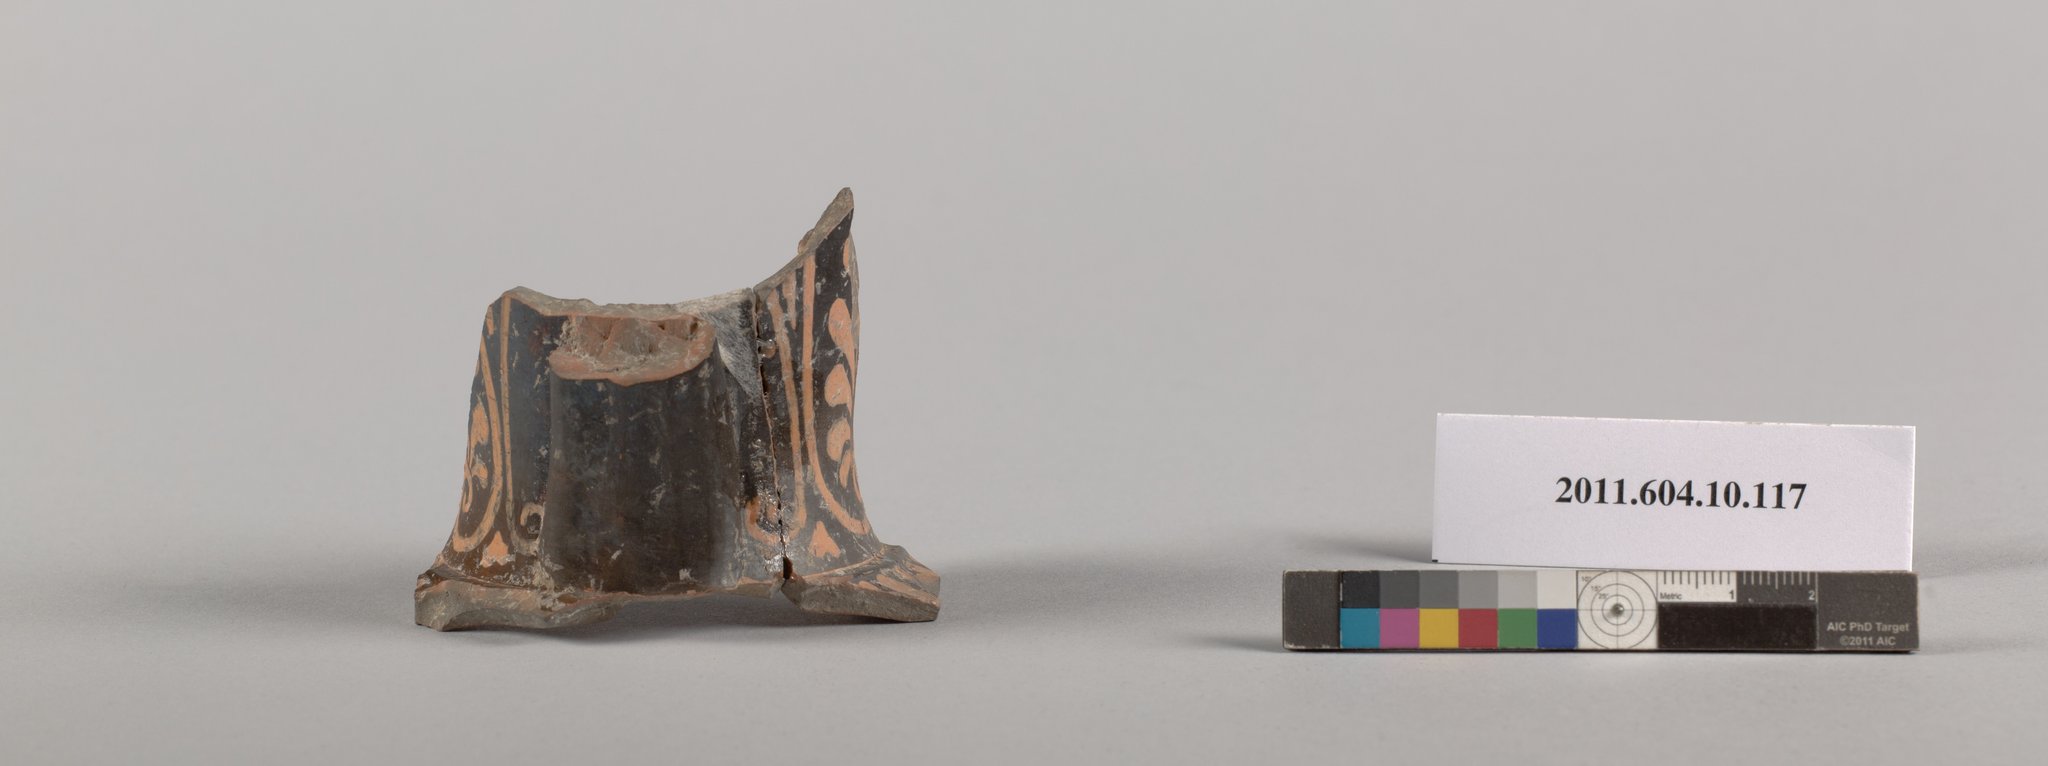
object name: pelike fragment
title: Terracotta fragment of a pelike (jar)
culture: etruscan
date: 434-368 BCE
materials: terracotta